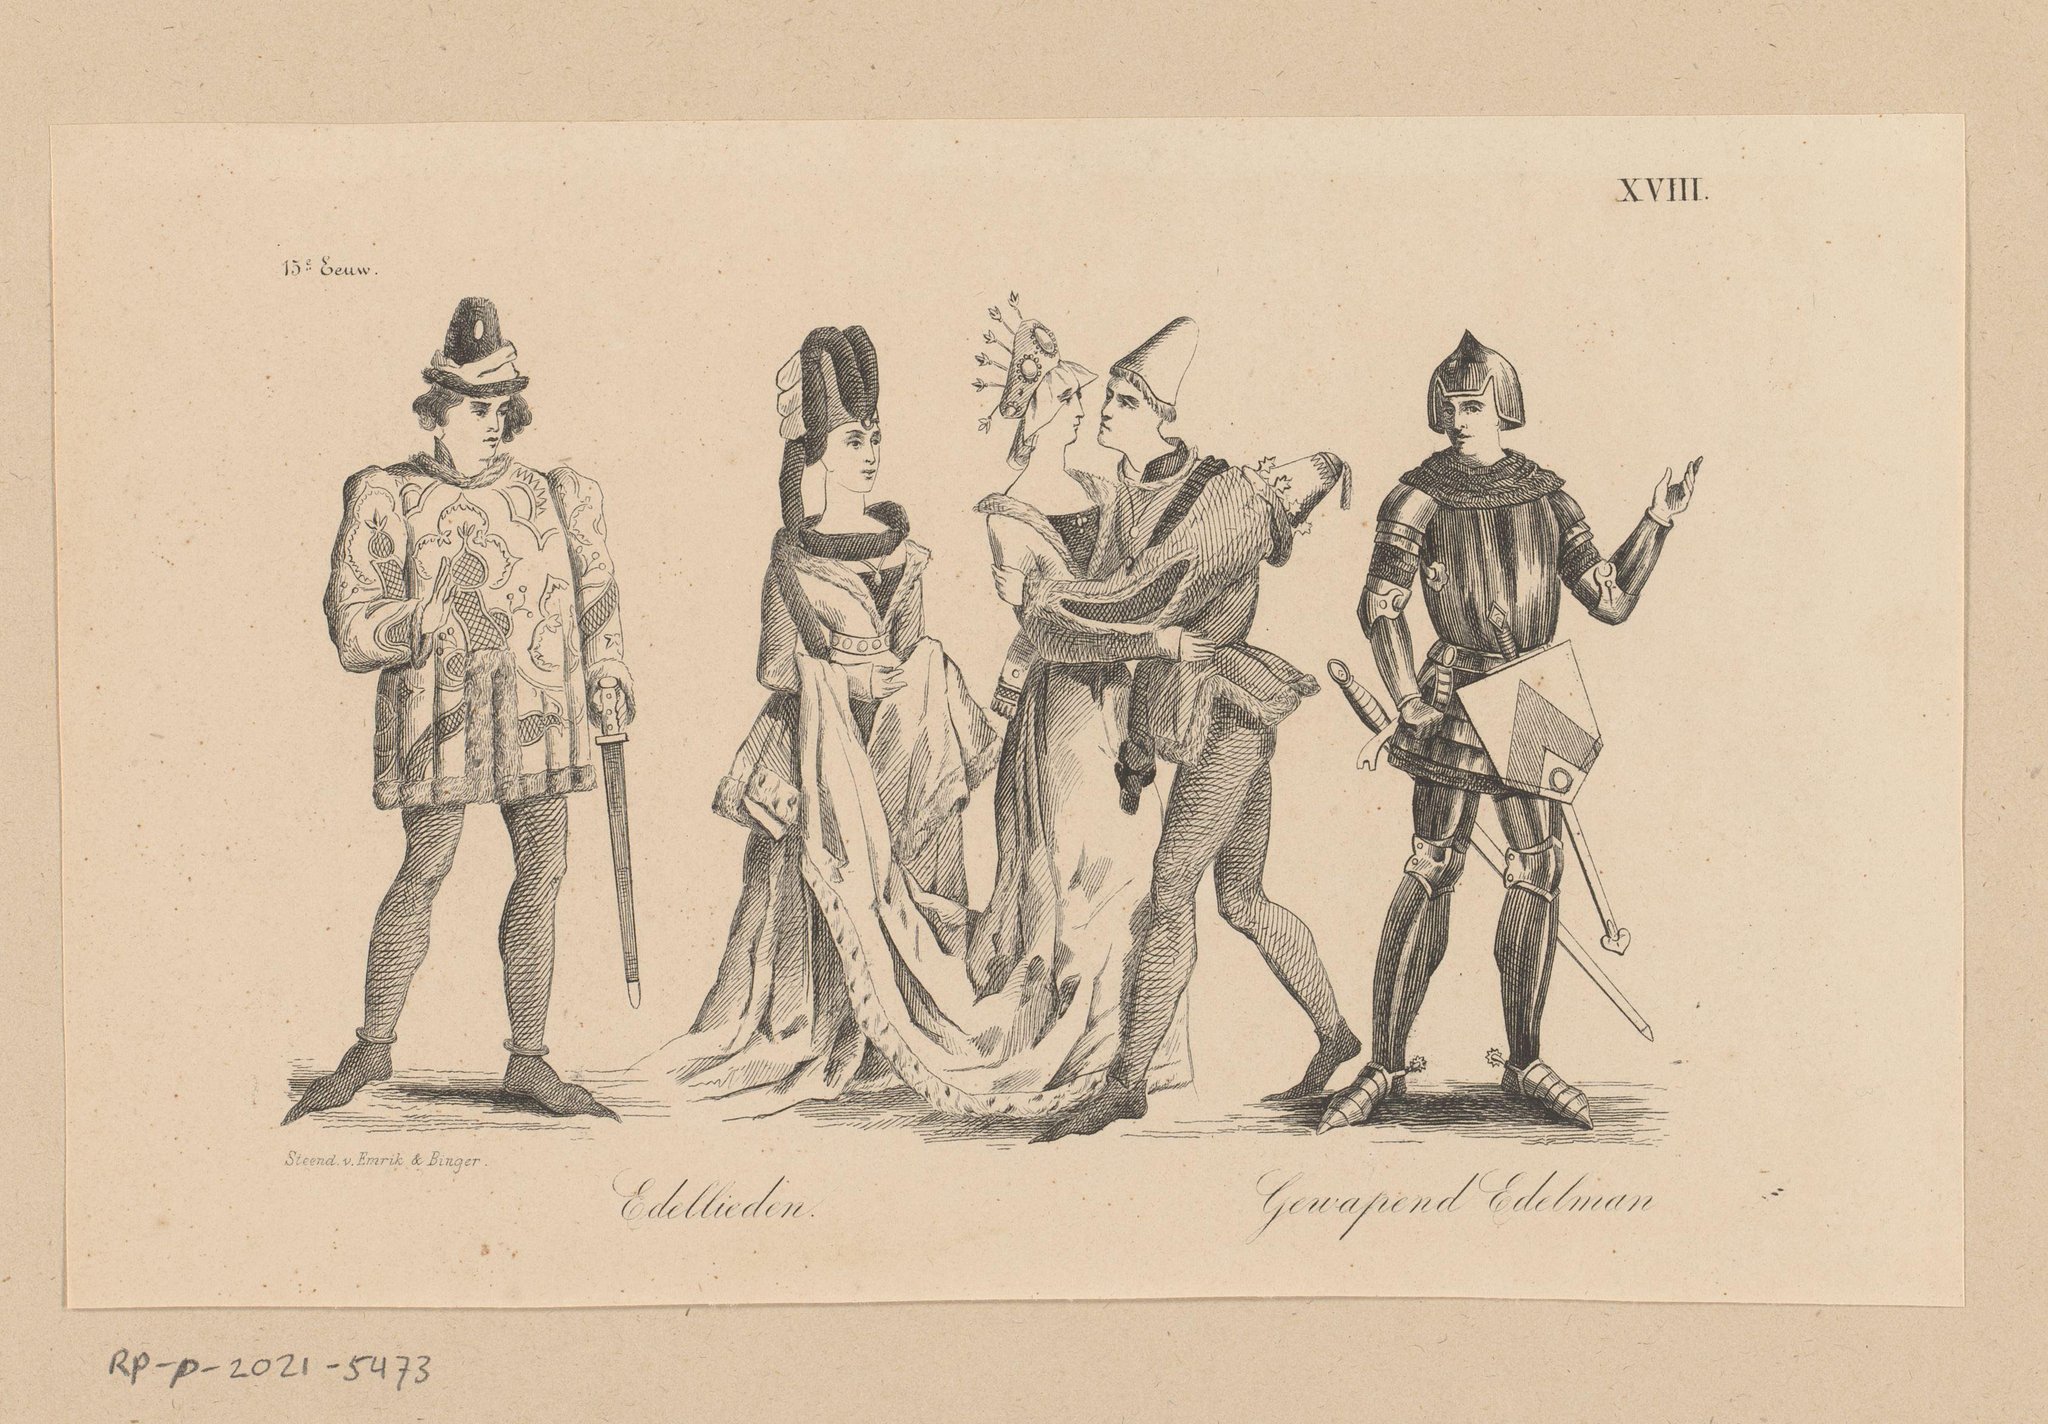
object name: print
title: Edellieden / Gewapend Edelman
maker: Anonymous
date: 1857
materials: paper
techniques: lithograph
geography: netherlands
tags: armour, hacking and thrusting weapons: sword, clothes, costume, lovers; courting, flirting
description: Prent waarschijnlijk uit: Hofdijk, Willem Jacob. Schets van de geschiedenis der Nederlanden. Amsterdam: Gebroeders Binger, 1857.